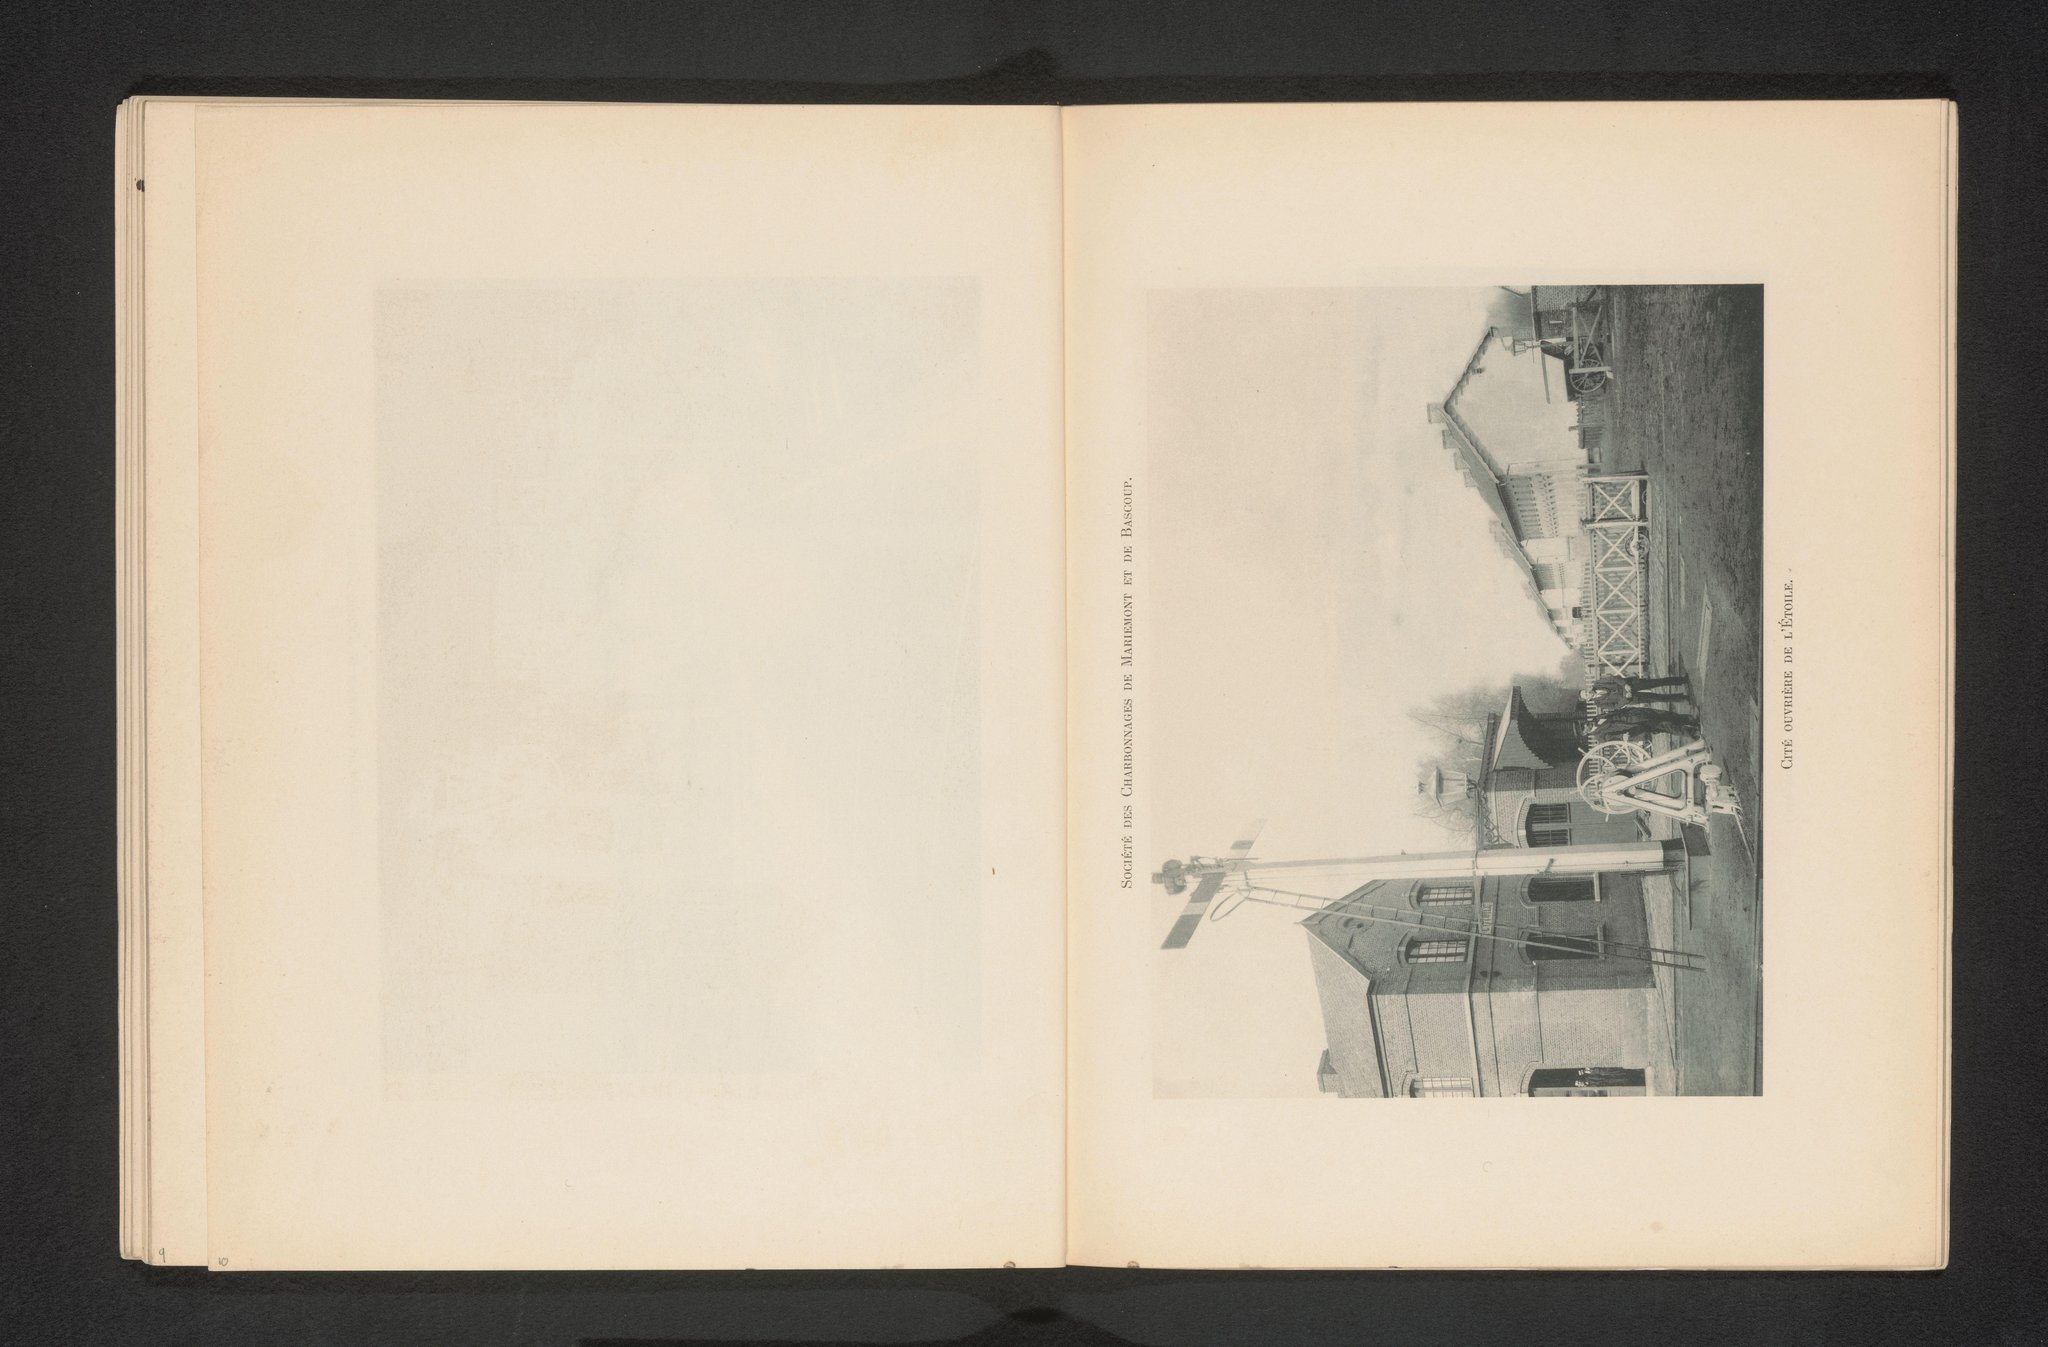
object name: photomechanical print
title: Werknemers in Cité de l'Étoile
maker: Anonymous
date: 1895-1900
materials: paper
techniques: photograph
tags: factory-building, housing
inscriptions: inscription: ‘Société des Charbonnages de Mariemont’